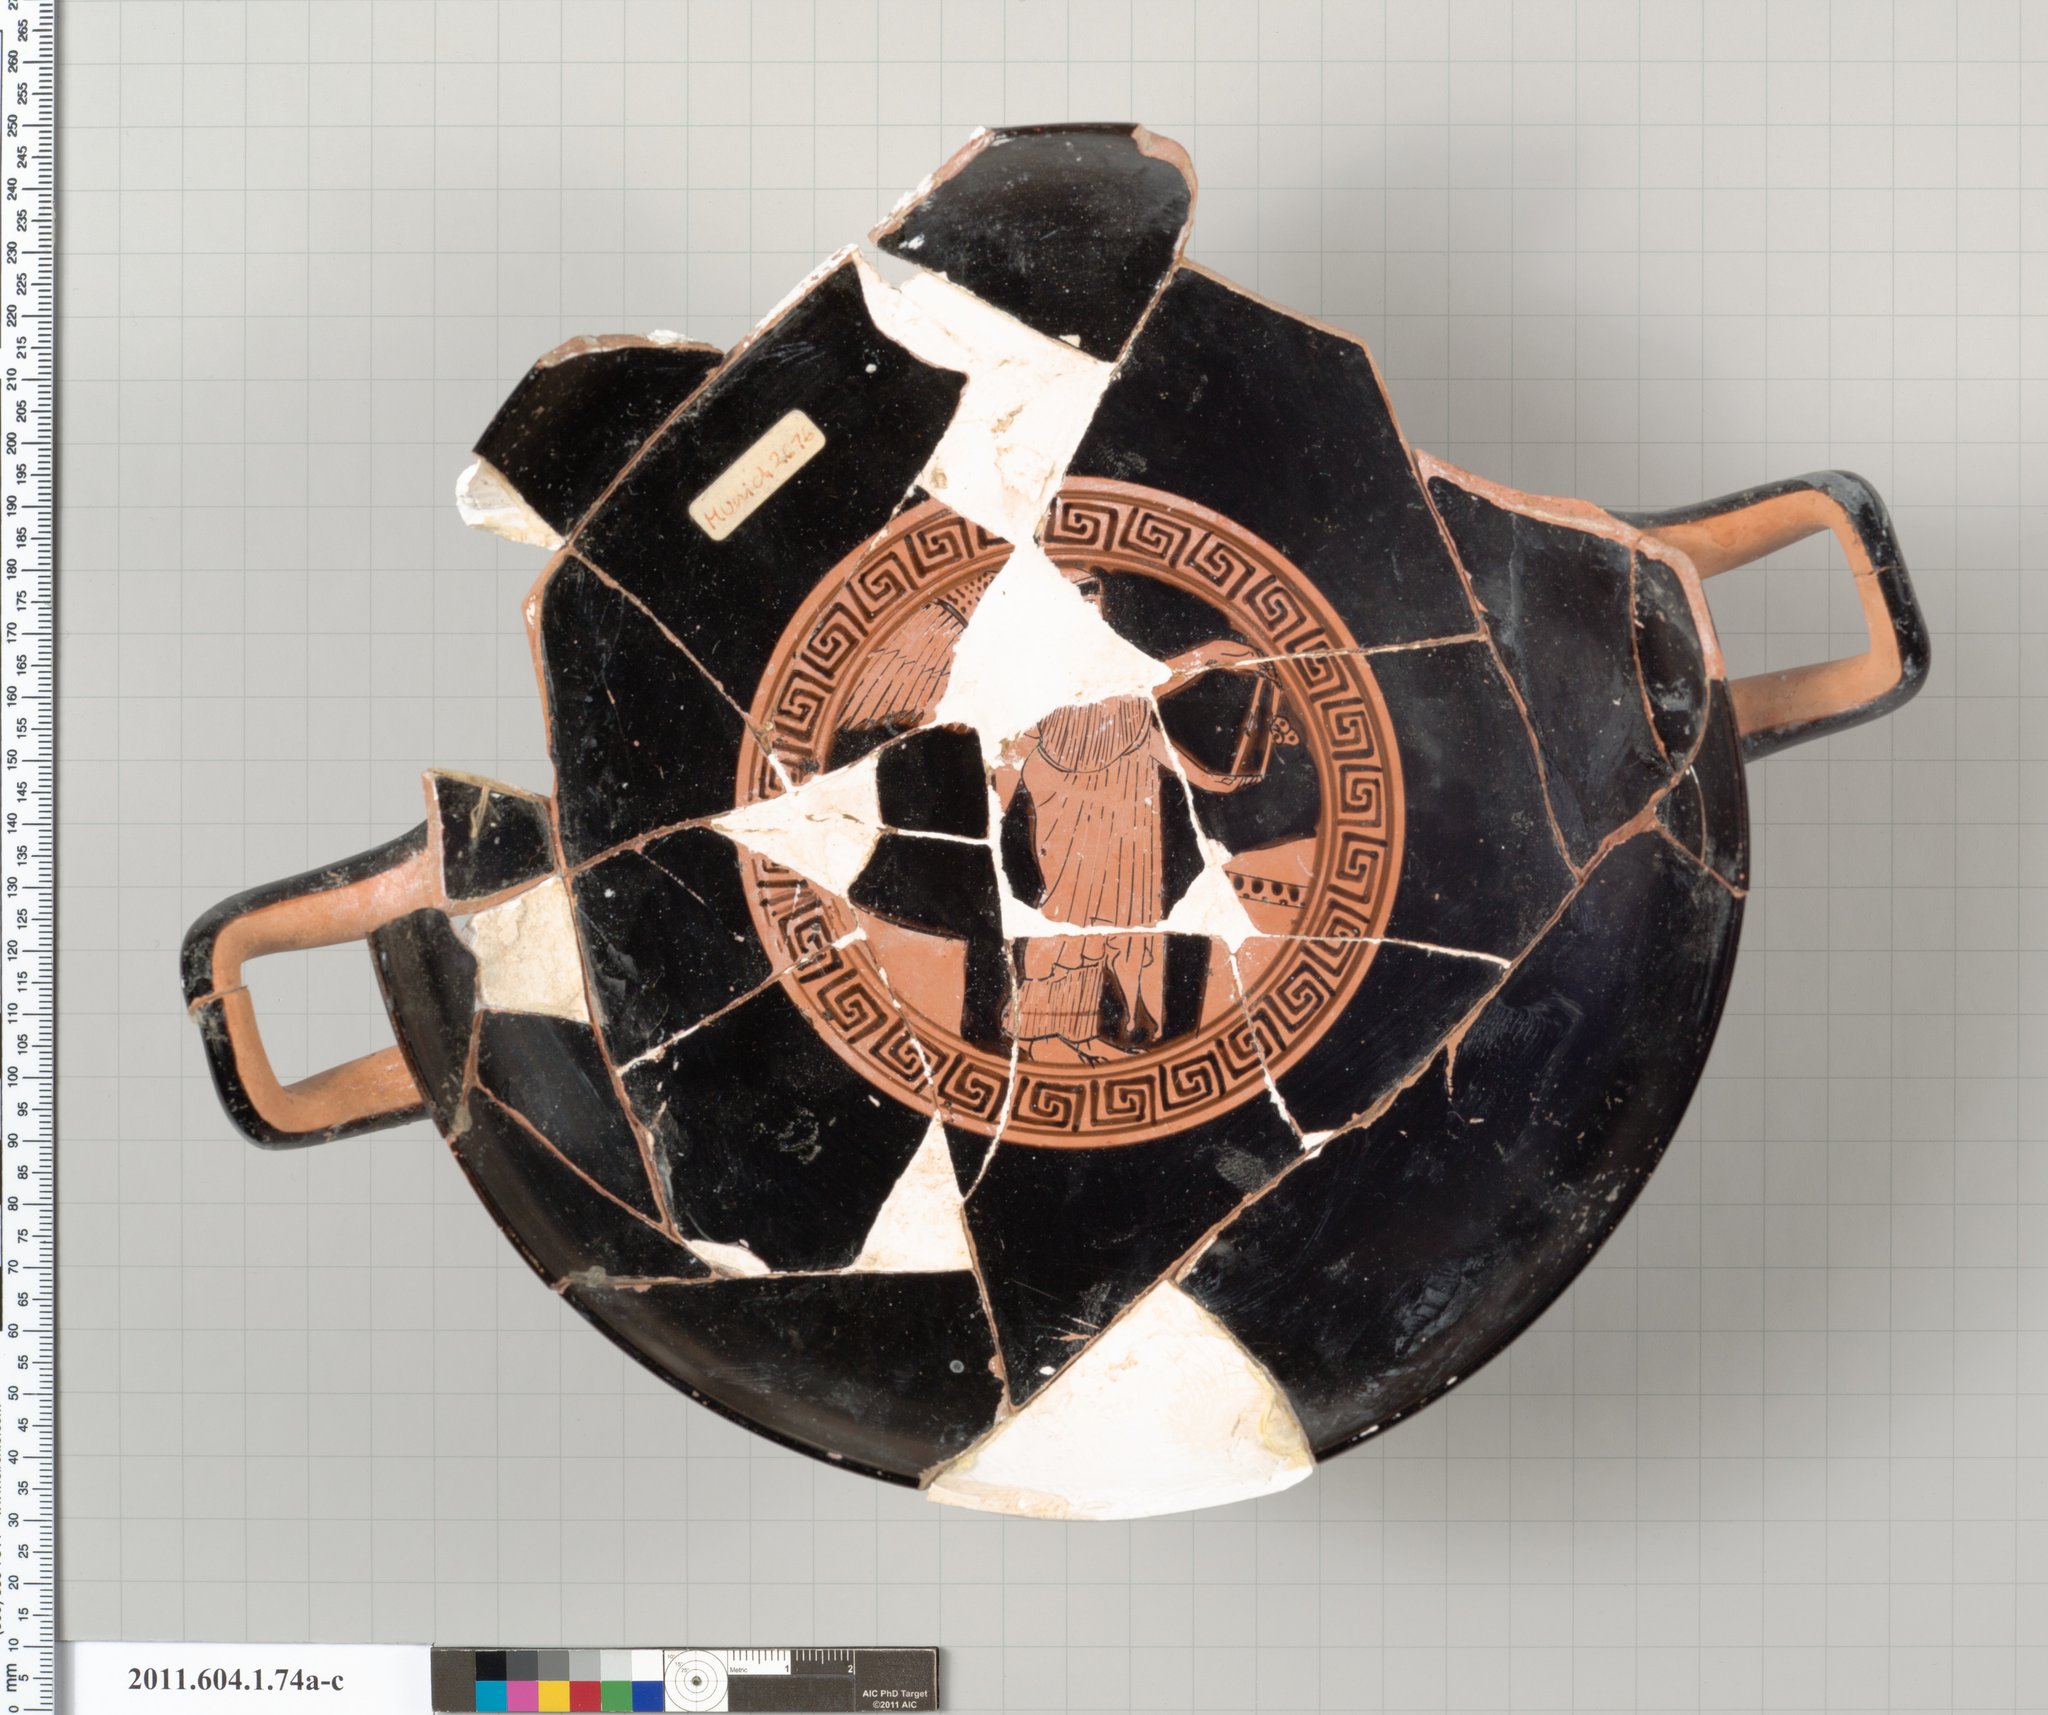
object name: kylix fragment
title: Terracotta fragments of a kylix (drinking cup)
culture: greek, attic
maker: painter of munich 2676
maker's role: artist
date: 470-460 BCE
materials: terracotta